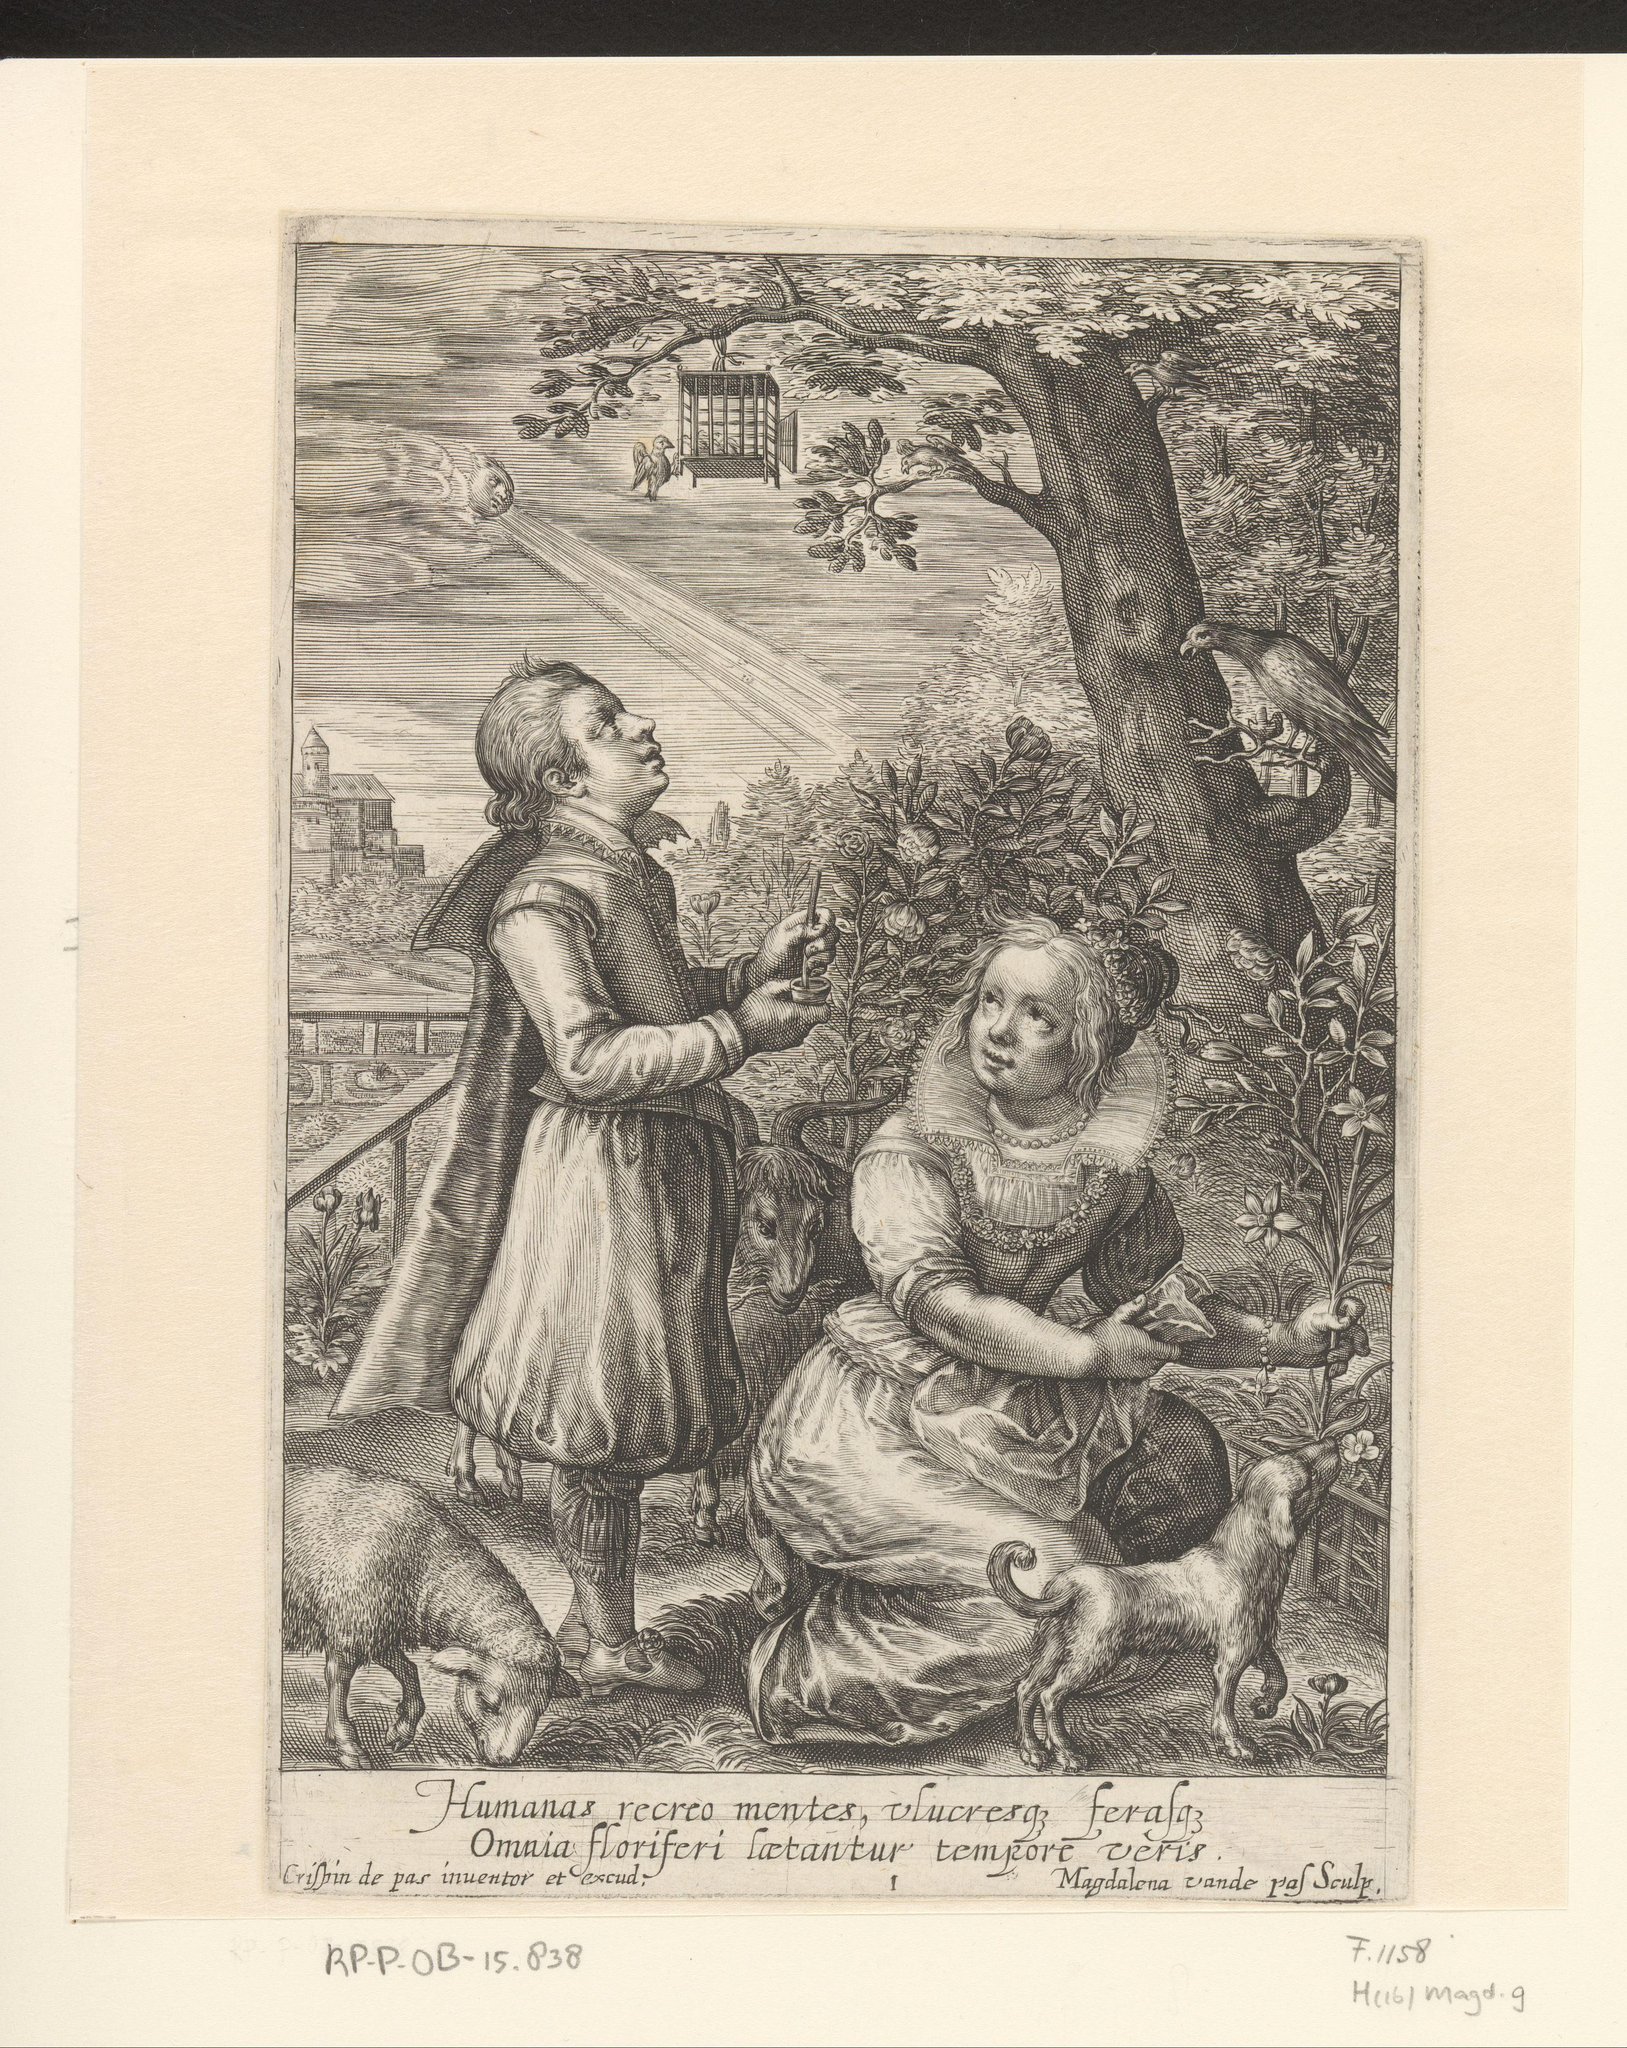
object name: print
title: Spring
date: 1617-1634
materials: paper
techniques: engraving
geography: utrecht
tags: spring, 'ver'; 'primavera' (ripa) (+ ways of representing seasons and months), bird in a cage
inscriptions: collector's mark: Lugt 240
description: The boy’s upward gaze causes a curious element in this print to jump out, namely the cage with young birds hanging from the tree. The door is open, and the little birds can fly out. In 17th-century Dutch art this detail usually signifies the loss of virginity. But whether Magdalena van de Passe – Crispijn’s daughter – actually alludes to this here is open to discussion.